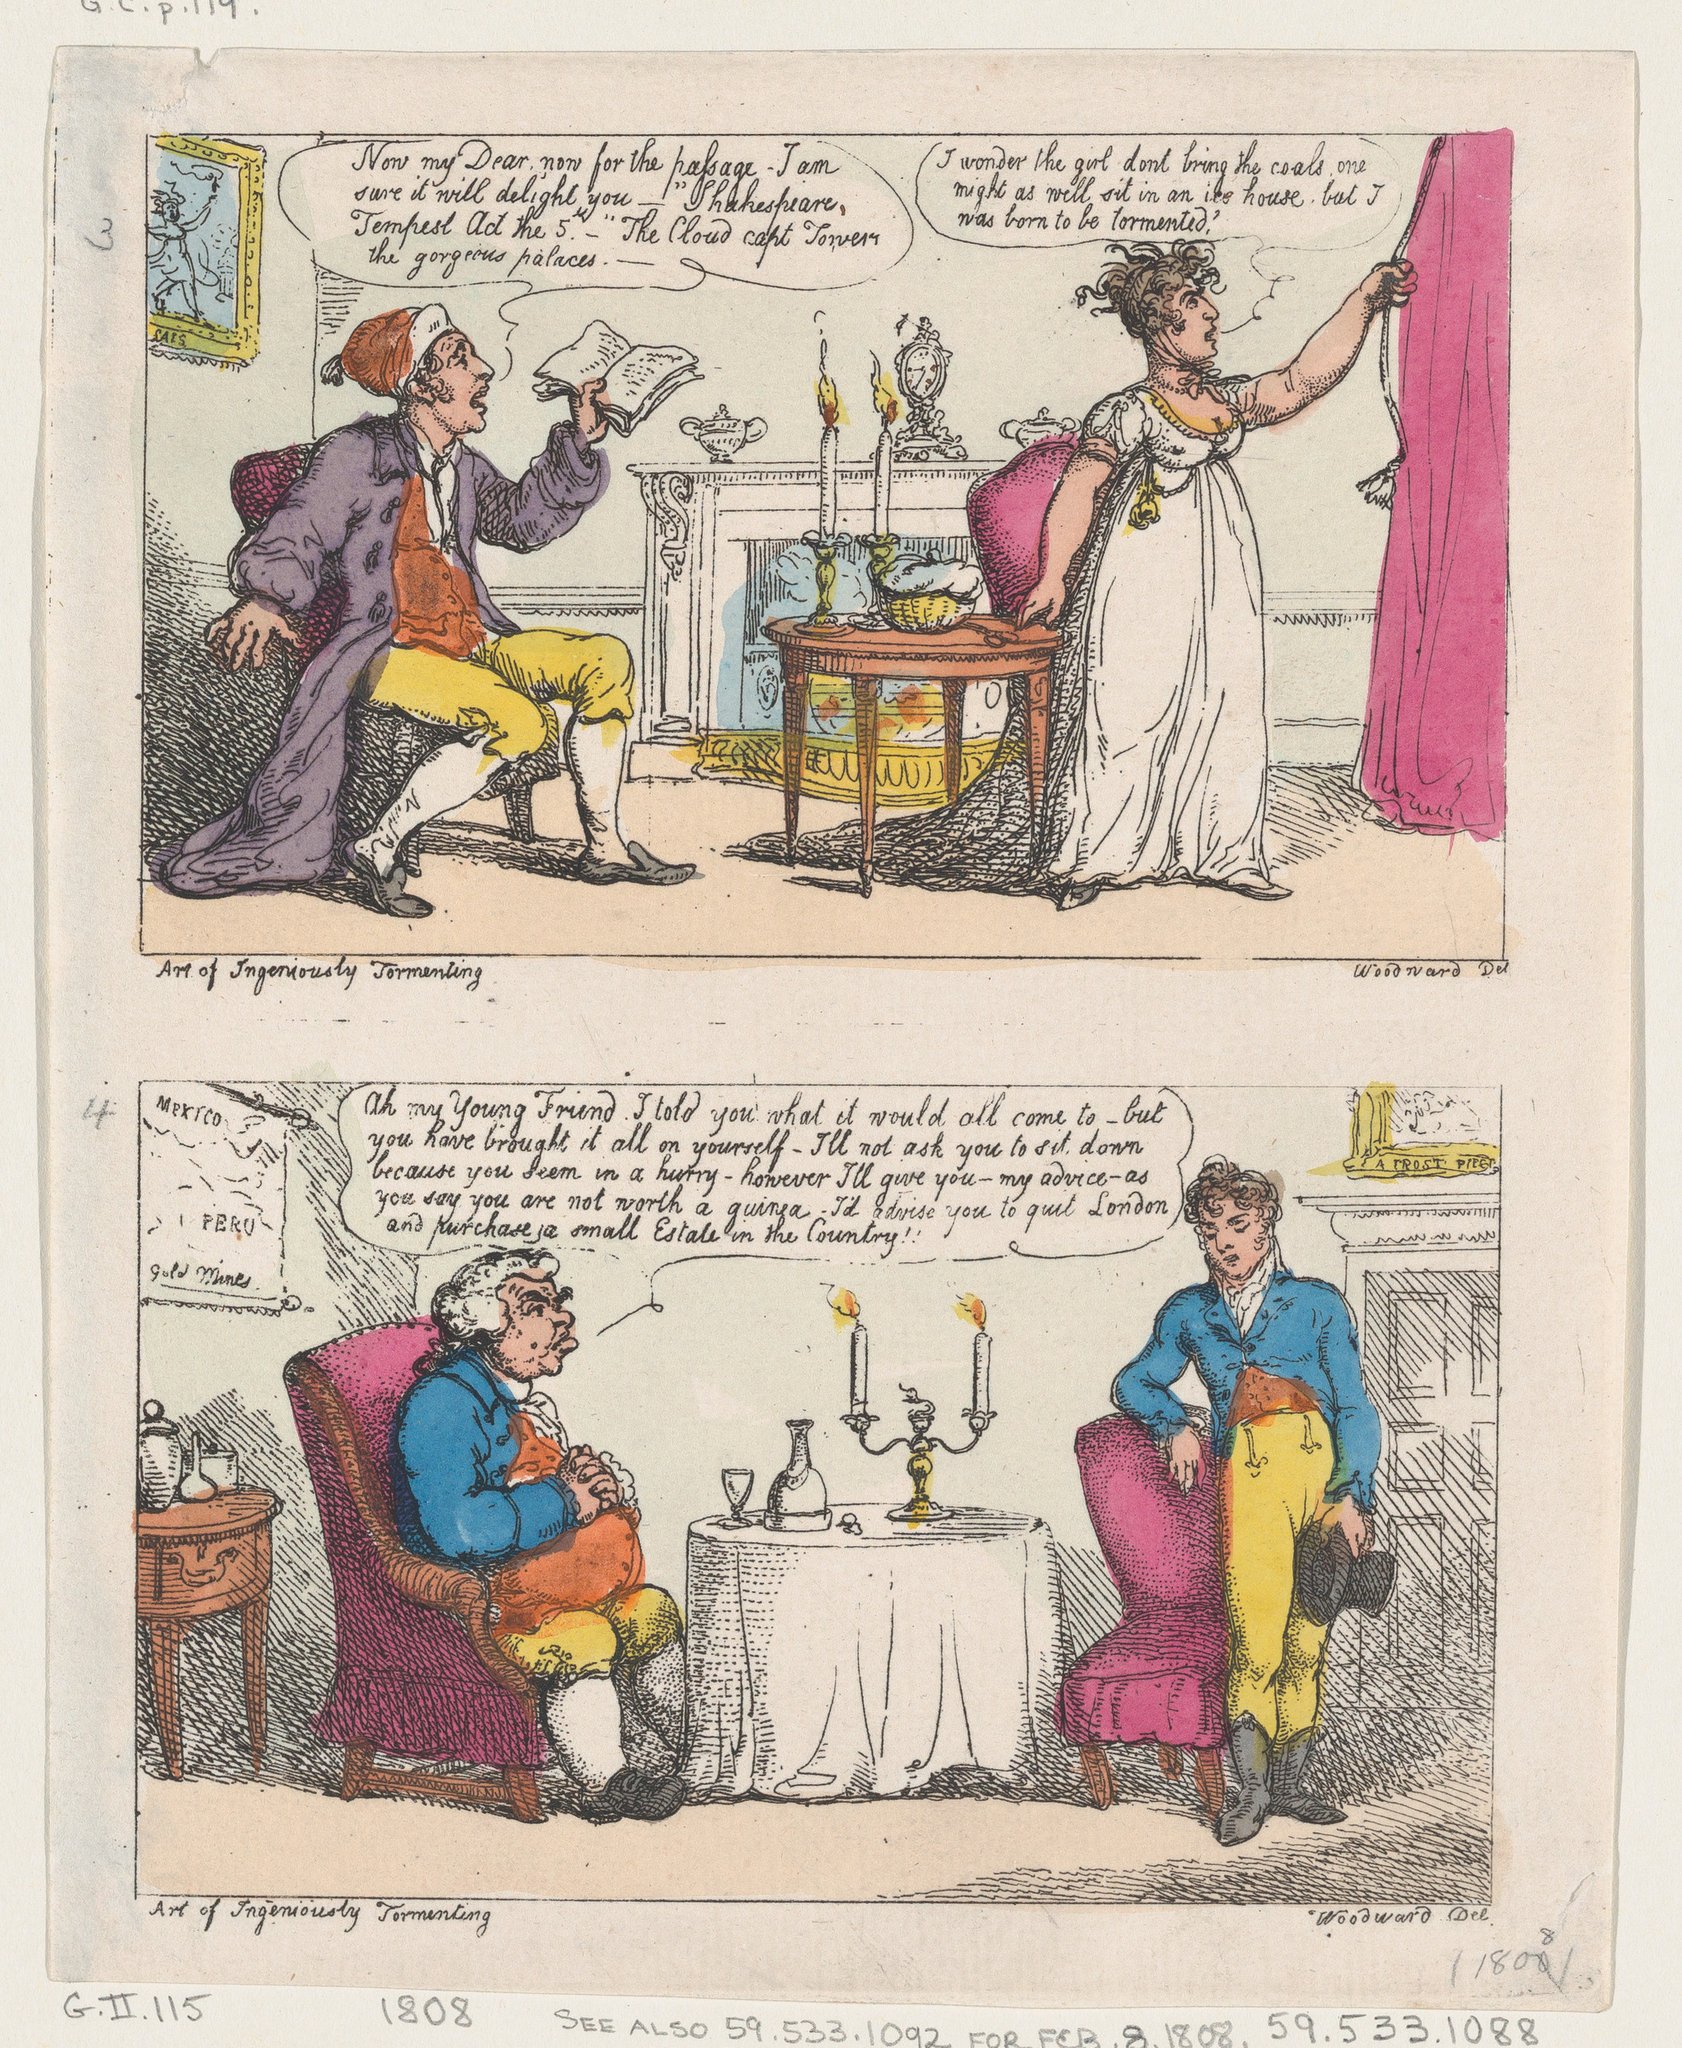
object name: print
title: The Art of Ingeniously Tormenting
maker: thomas rowlandson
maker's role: artist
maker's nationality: british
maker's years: 1757-1827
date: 1808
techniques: etching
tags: satire,men,women